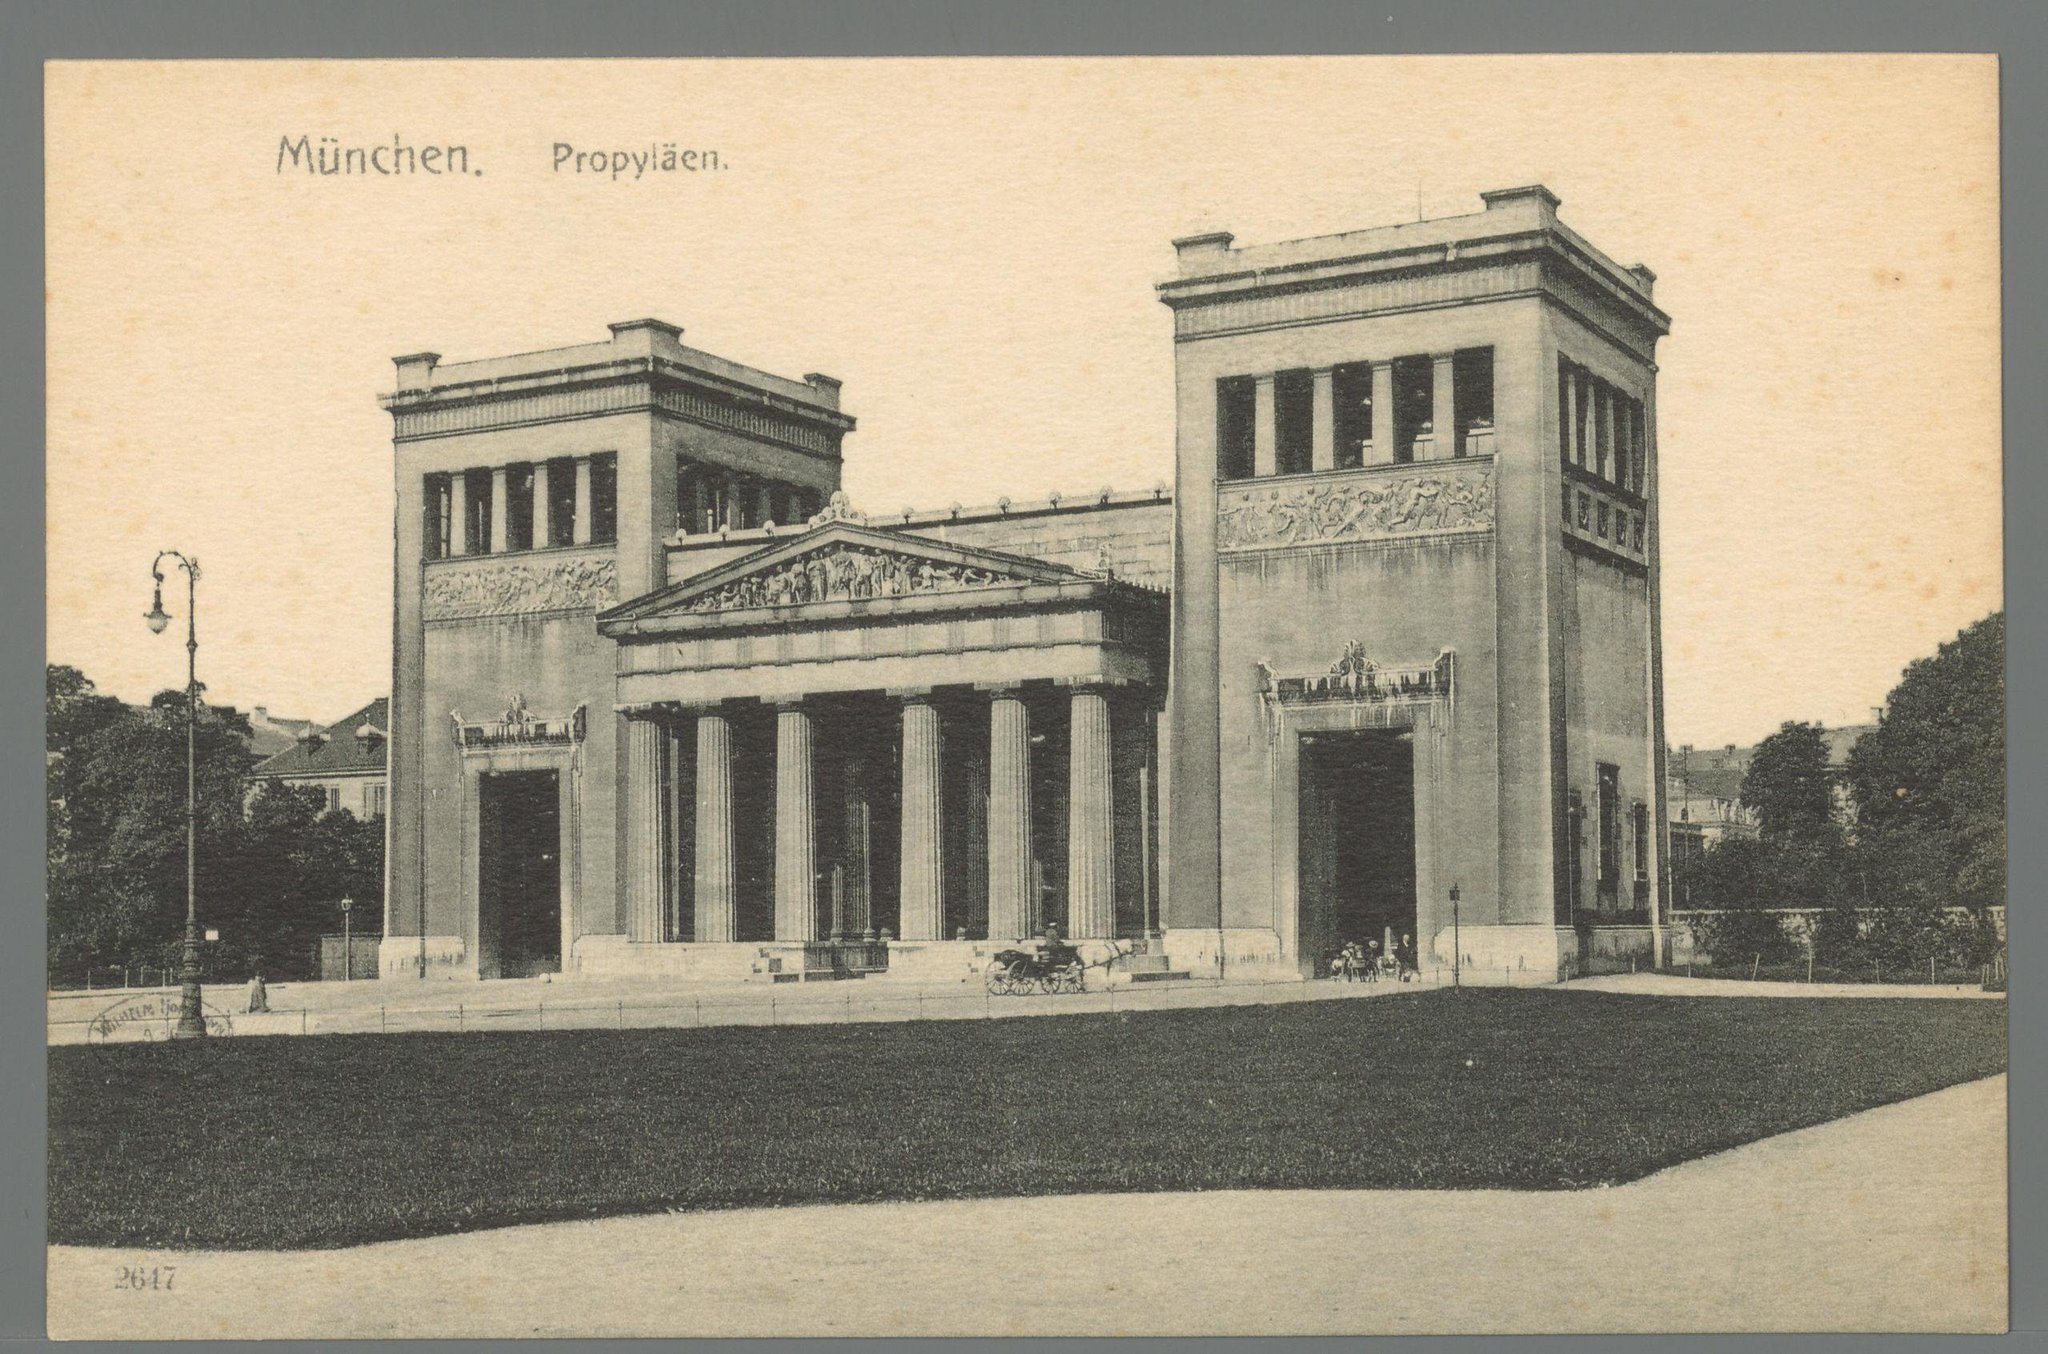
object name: photomechanical print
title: München. Propyläen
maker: Anonymous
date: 1905-1930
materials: cardboard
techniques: photograph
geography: dresden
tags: city-gate